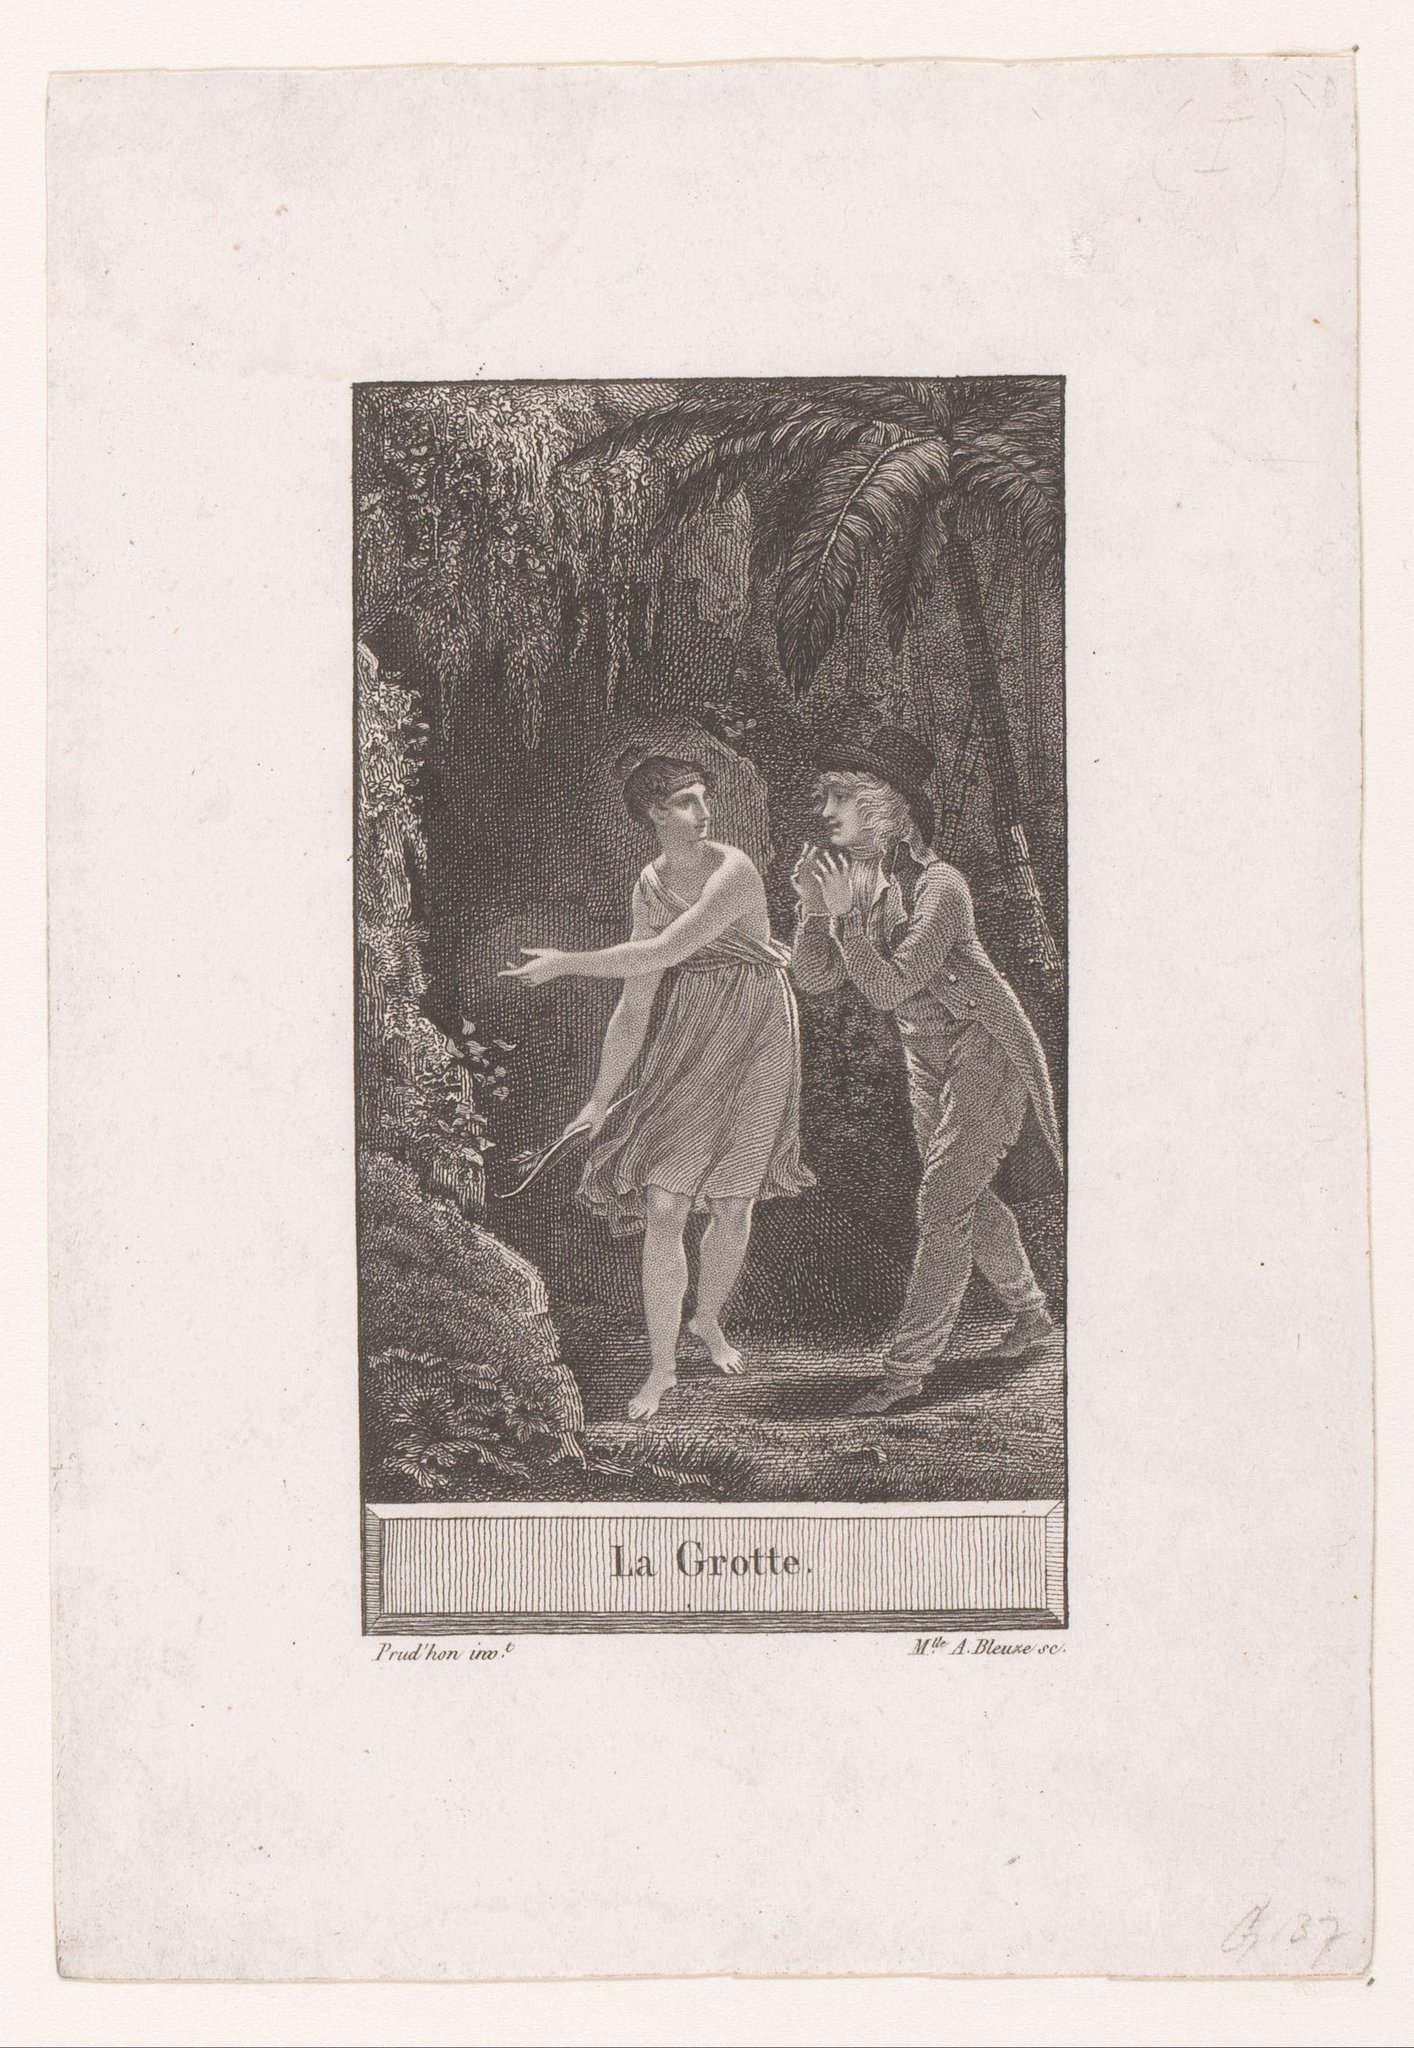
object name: book illustration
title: Stellina en Edouard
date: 1799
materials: paper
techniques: engraving, etching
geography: paris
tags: literary characters and objects, cave, grotto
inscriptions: collector's mark: Lugt 2228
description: Prent uit: Bonaparte, Lucien. La Tribu Indienne. Parijs: Honnert, 1799.